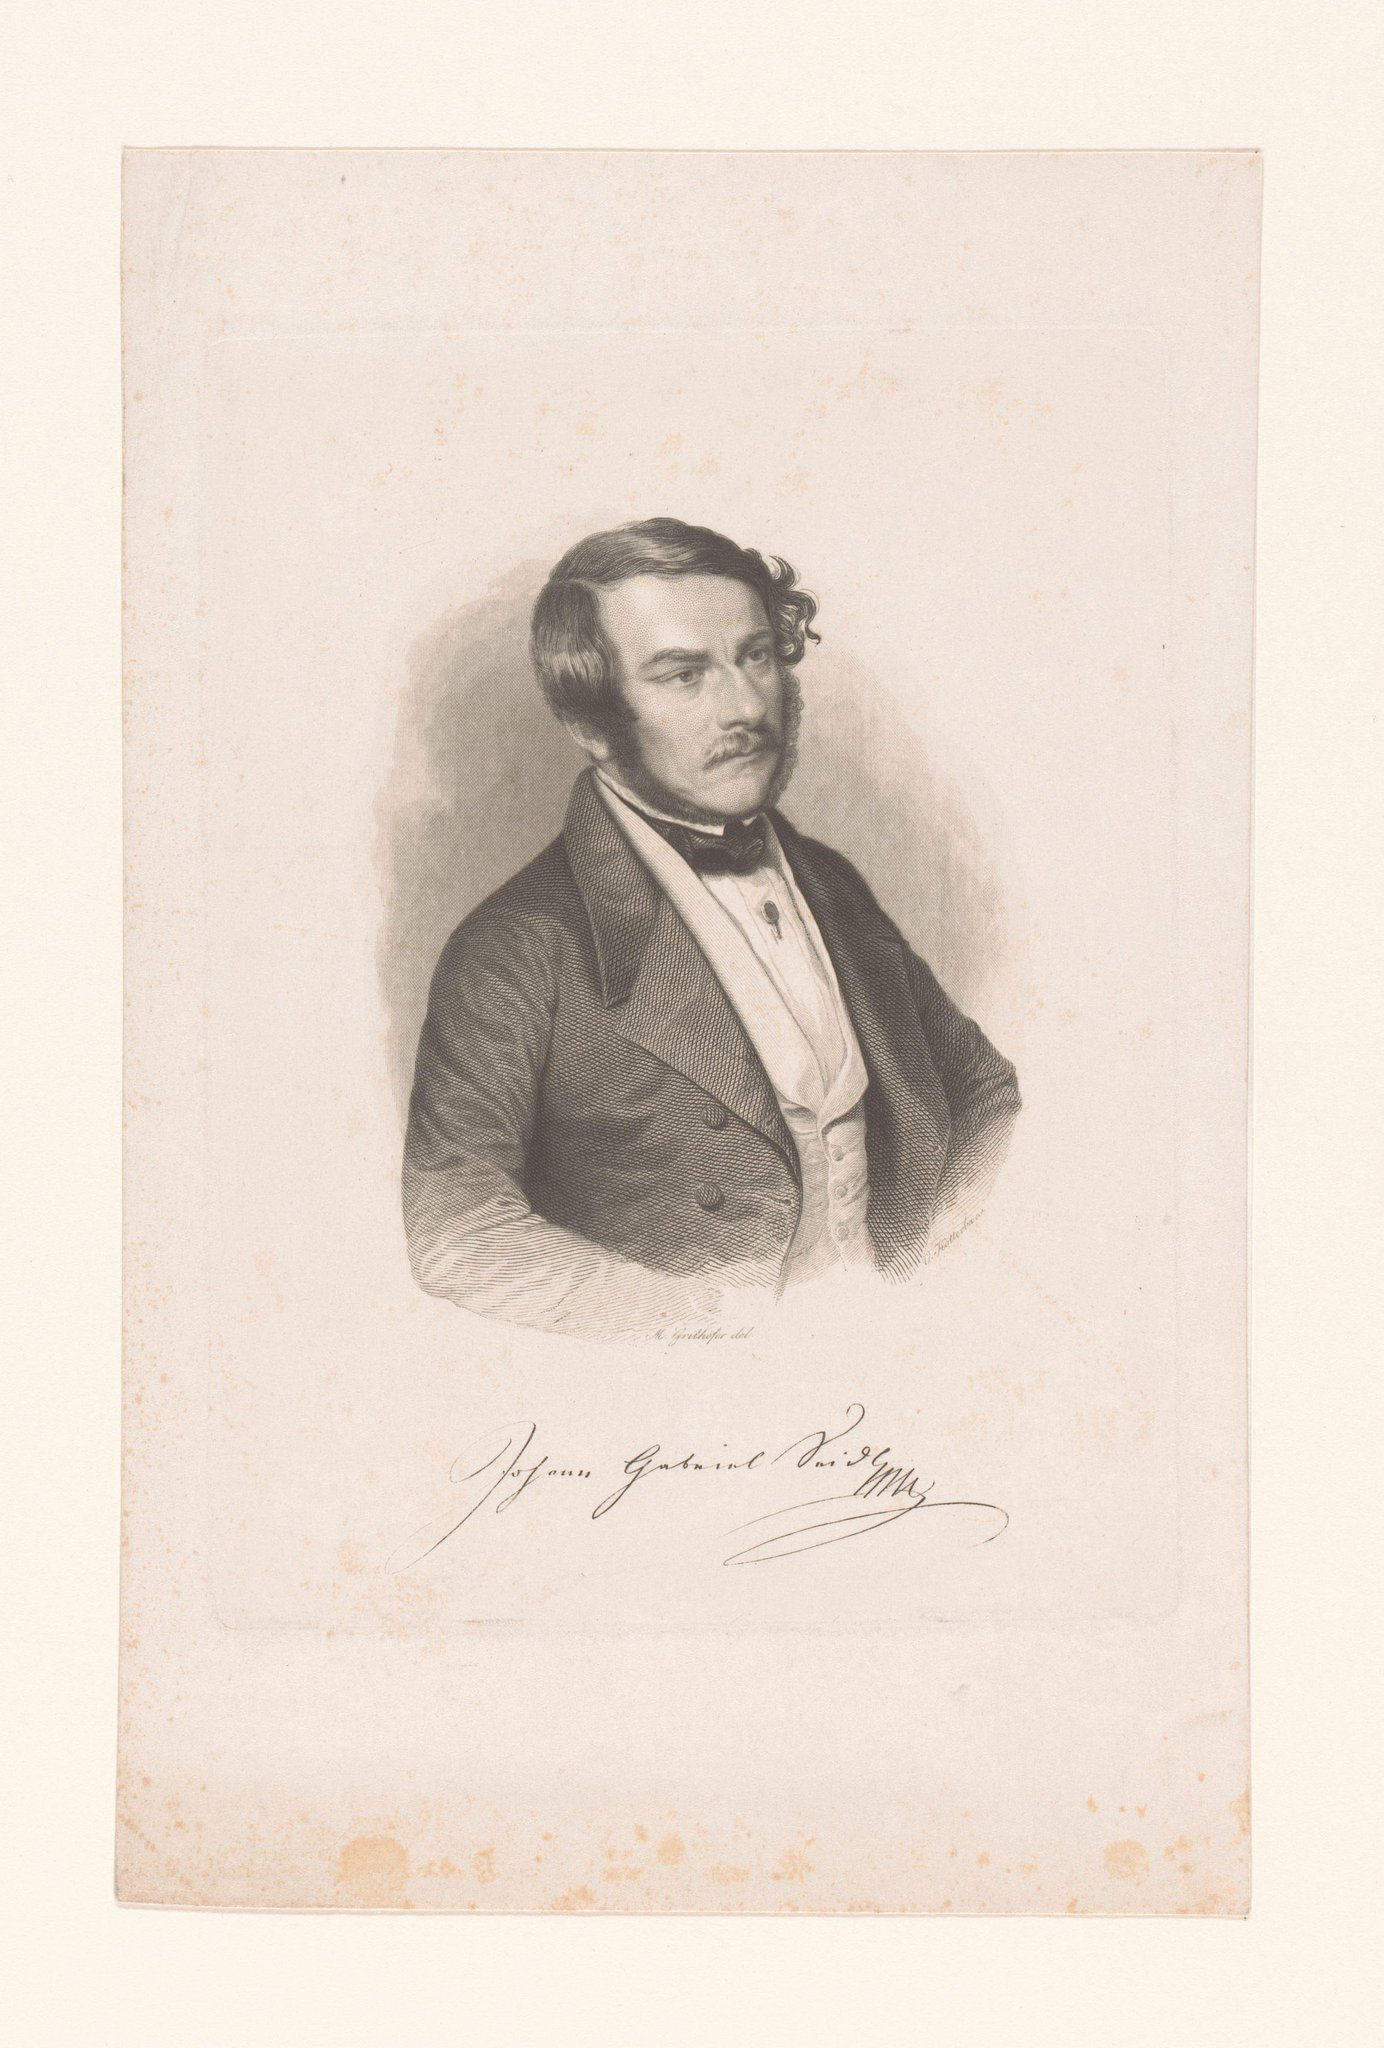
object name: print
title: Portret van Johann Gabriel Seidl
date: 1810-1859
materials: paper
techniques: engraving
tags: historical persons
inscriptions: collector's mark: Lugt 2228